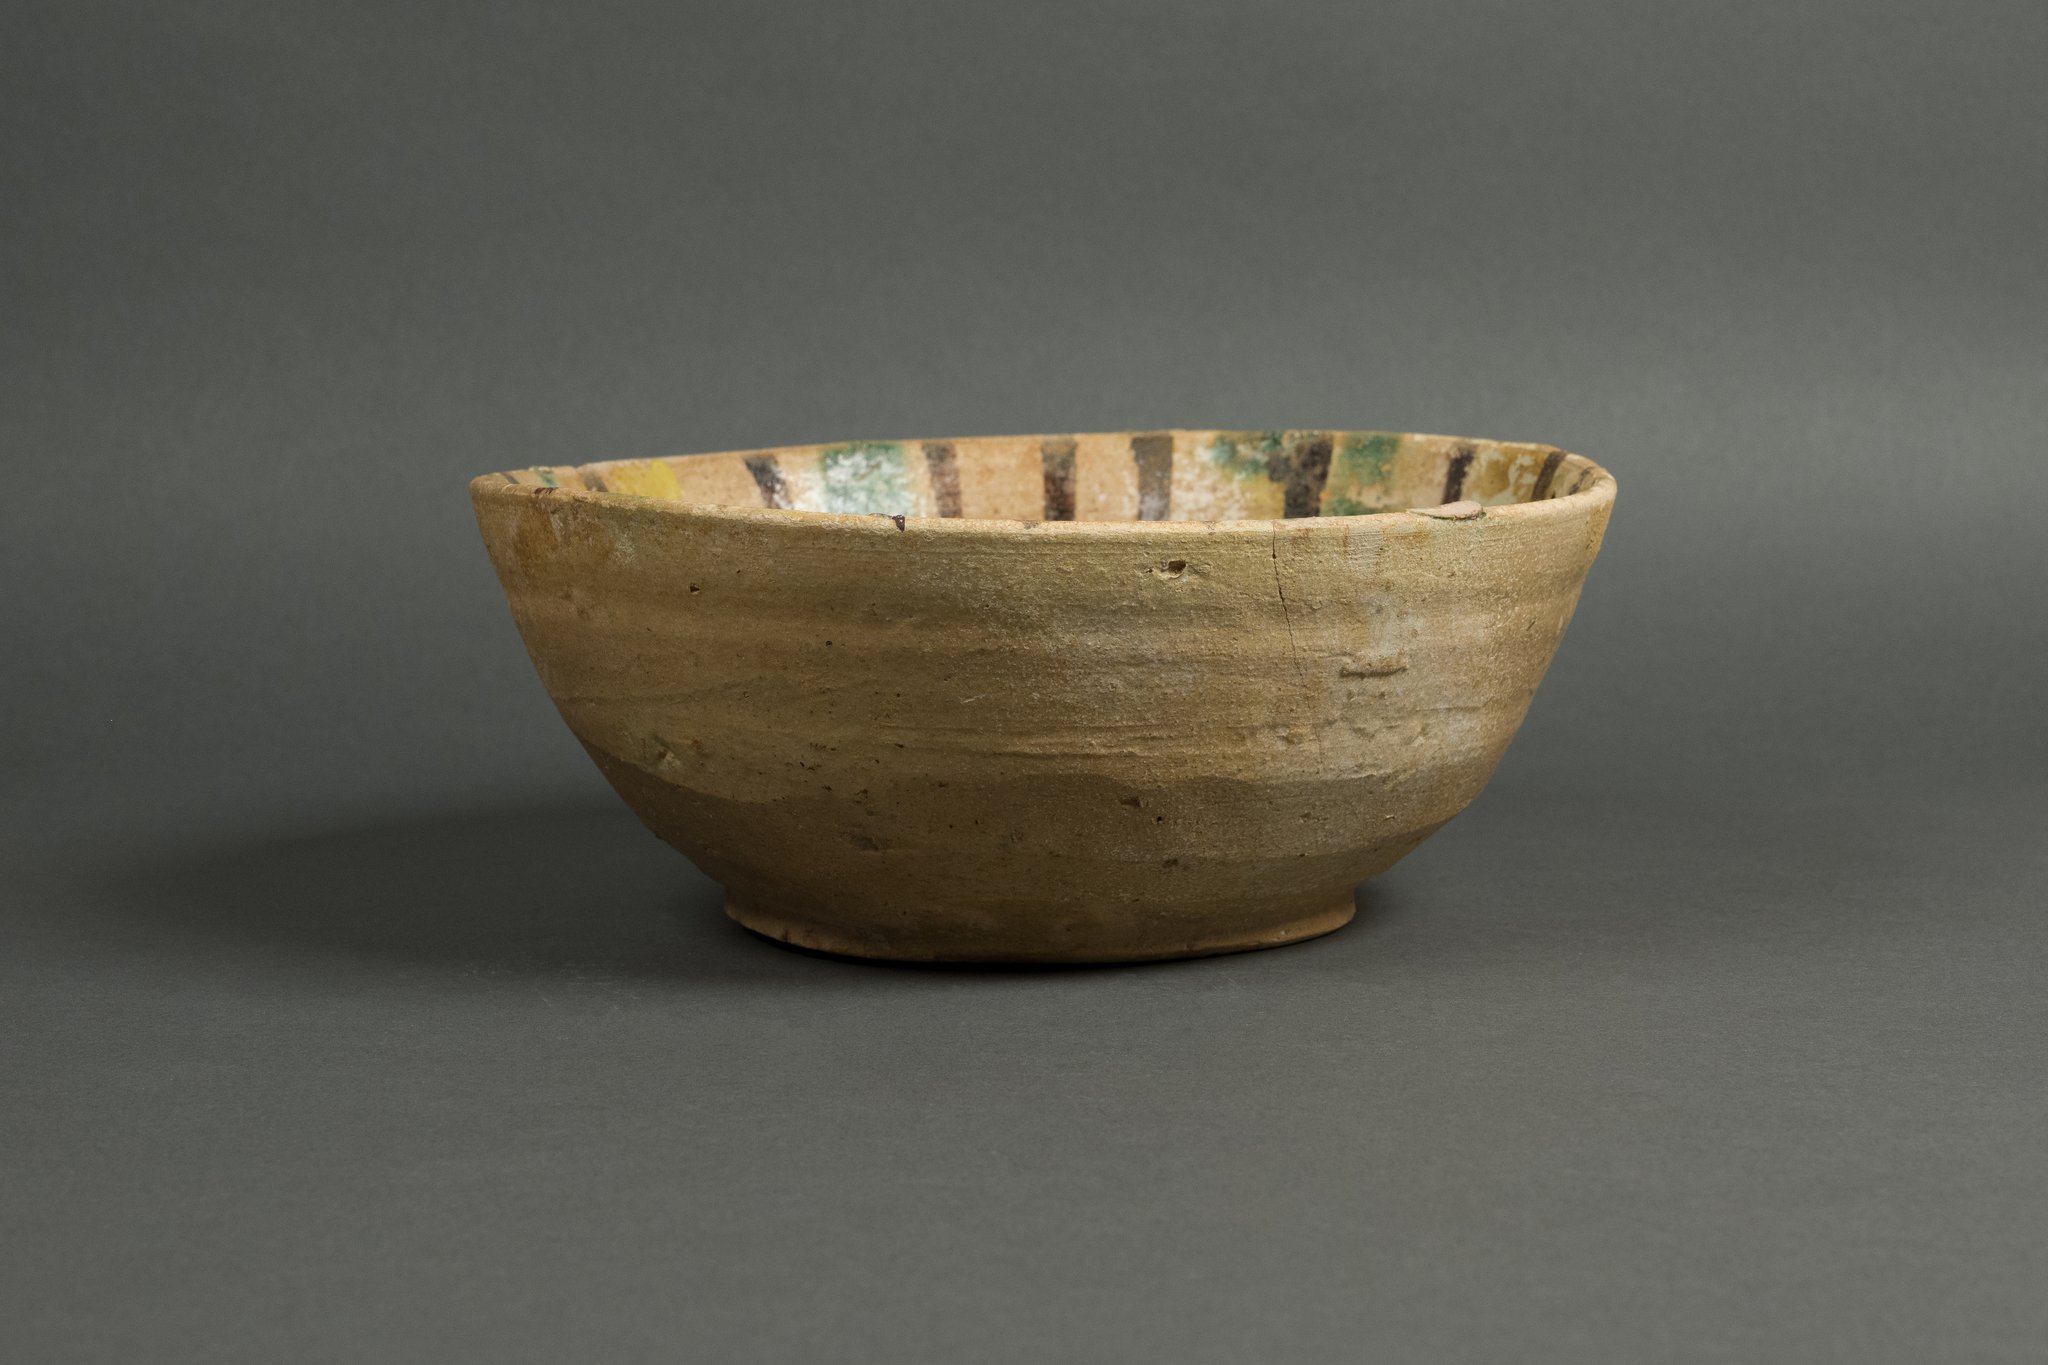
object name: bowl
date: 801-1000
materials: earthenware, glaze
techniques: polychrome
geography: iran